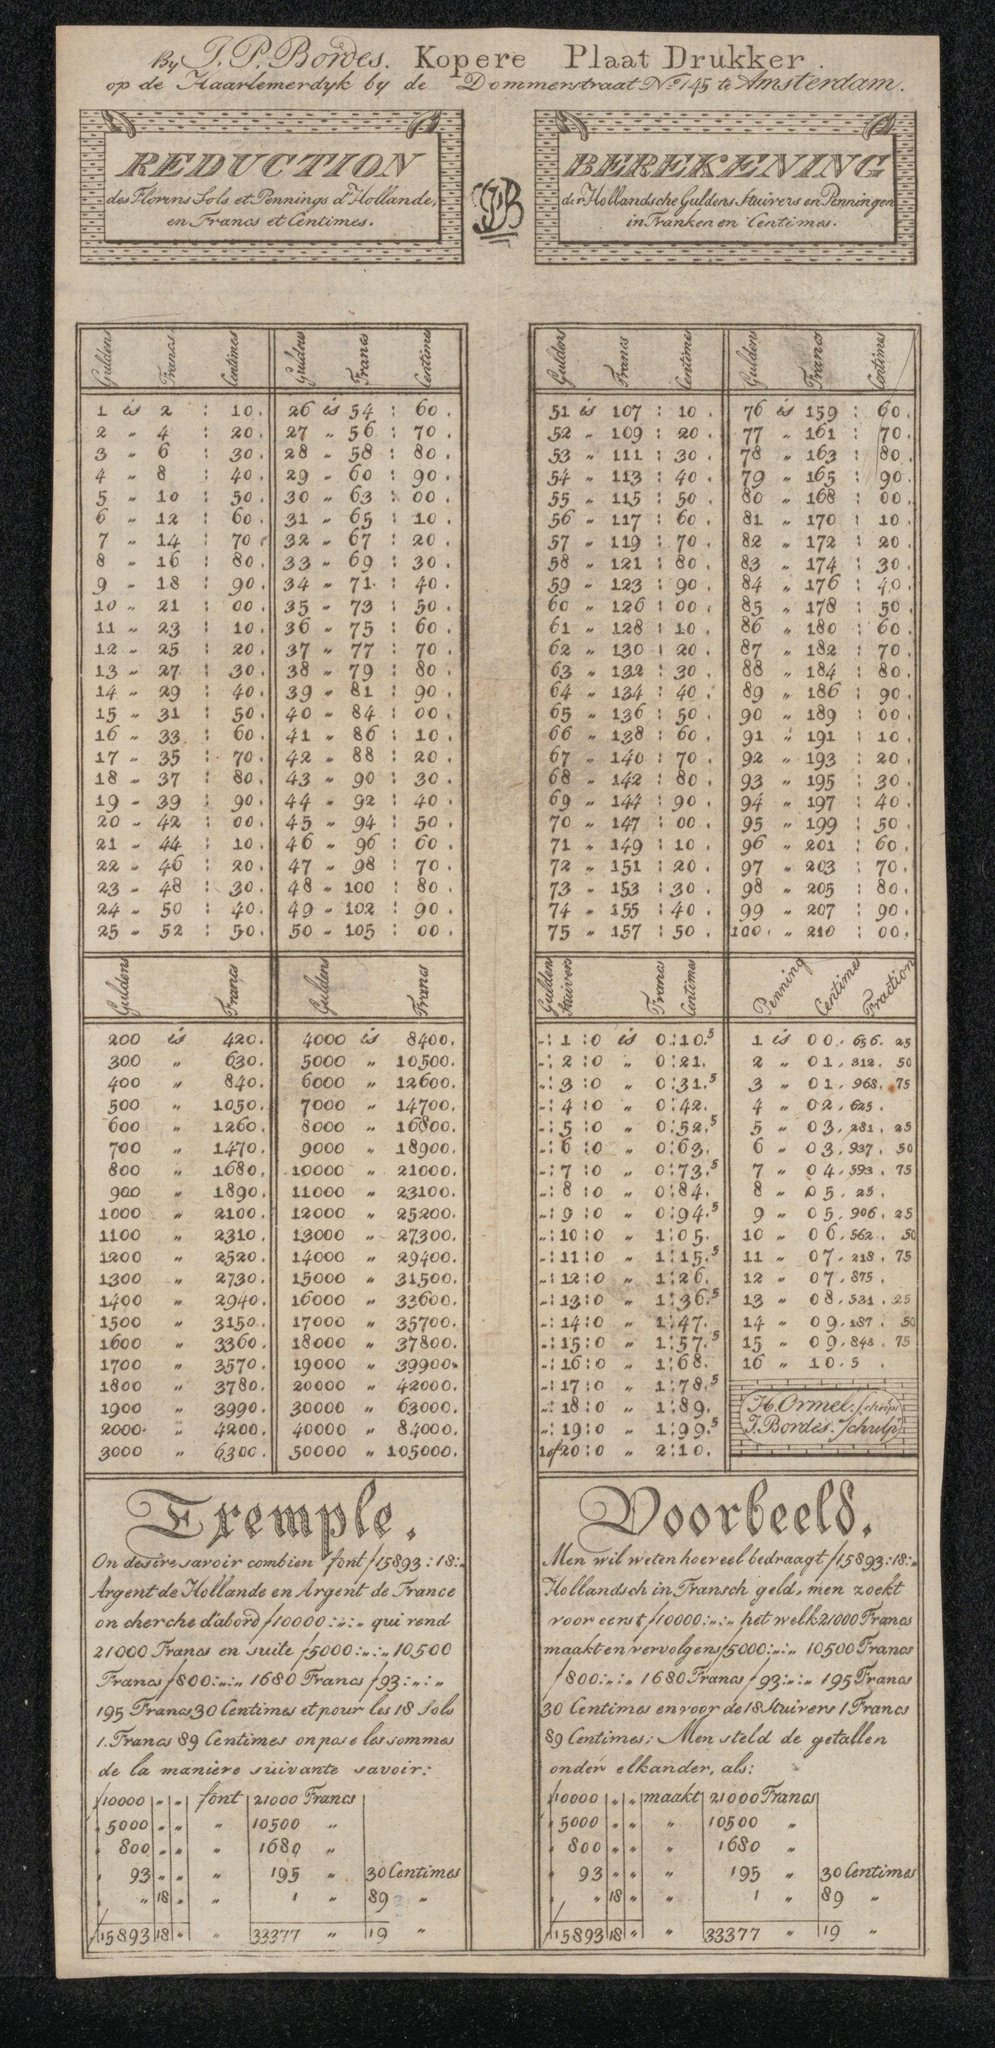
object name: document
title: Berekening der Hollandsche guldens, stuivers en penningen in franken en centimes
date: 1783-1838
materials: paper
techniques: printing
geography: amsterdam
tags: money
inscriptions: collector's mark: Lugt 2233